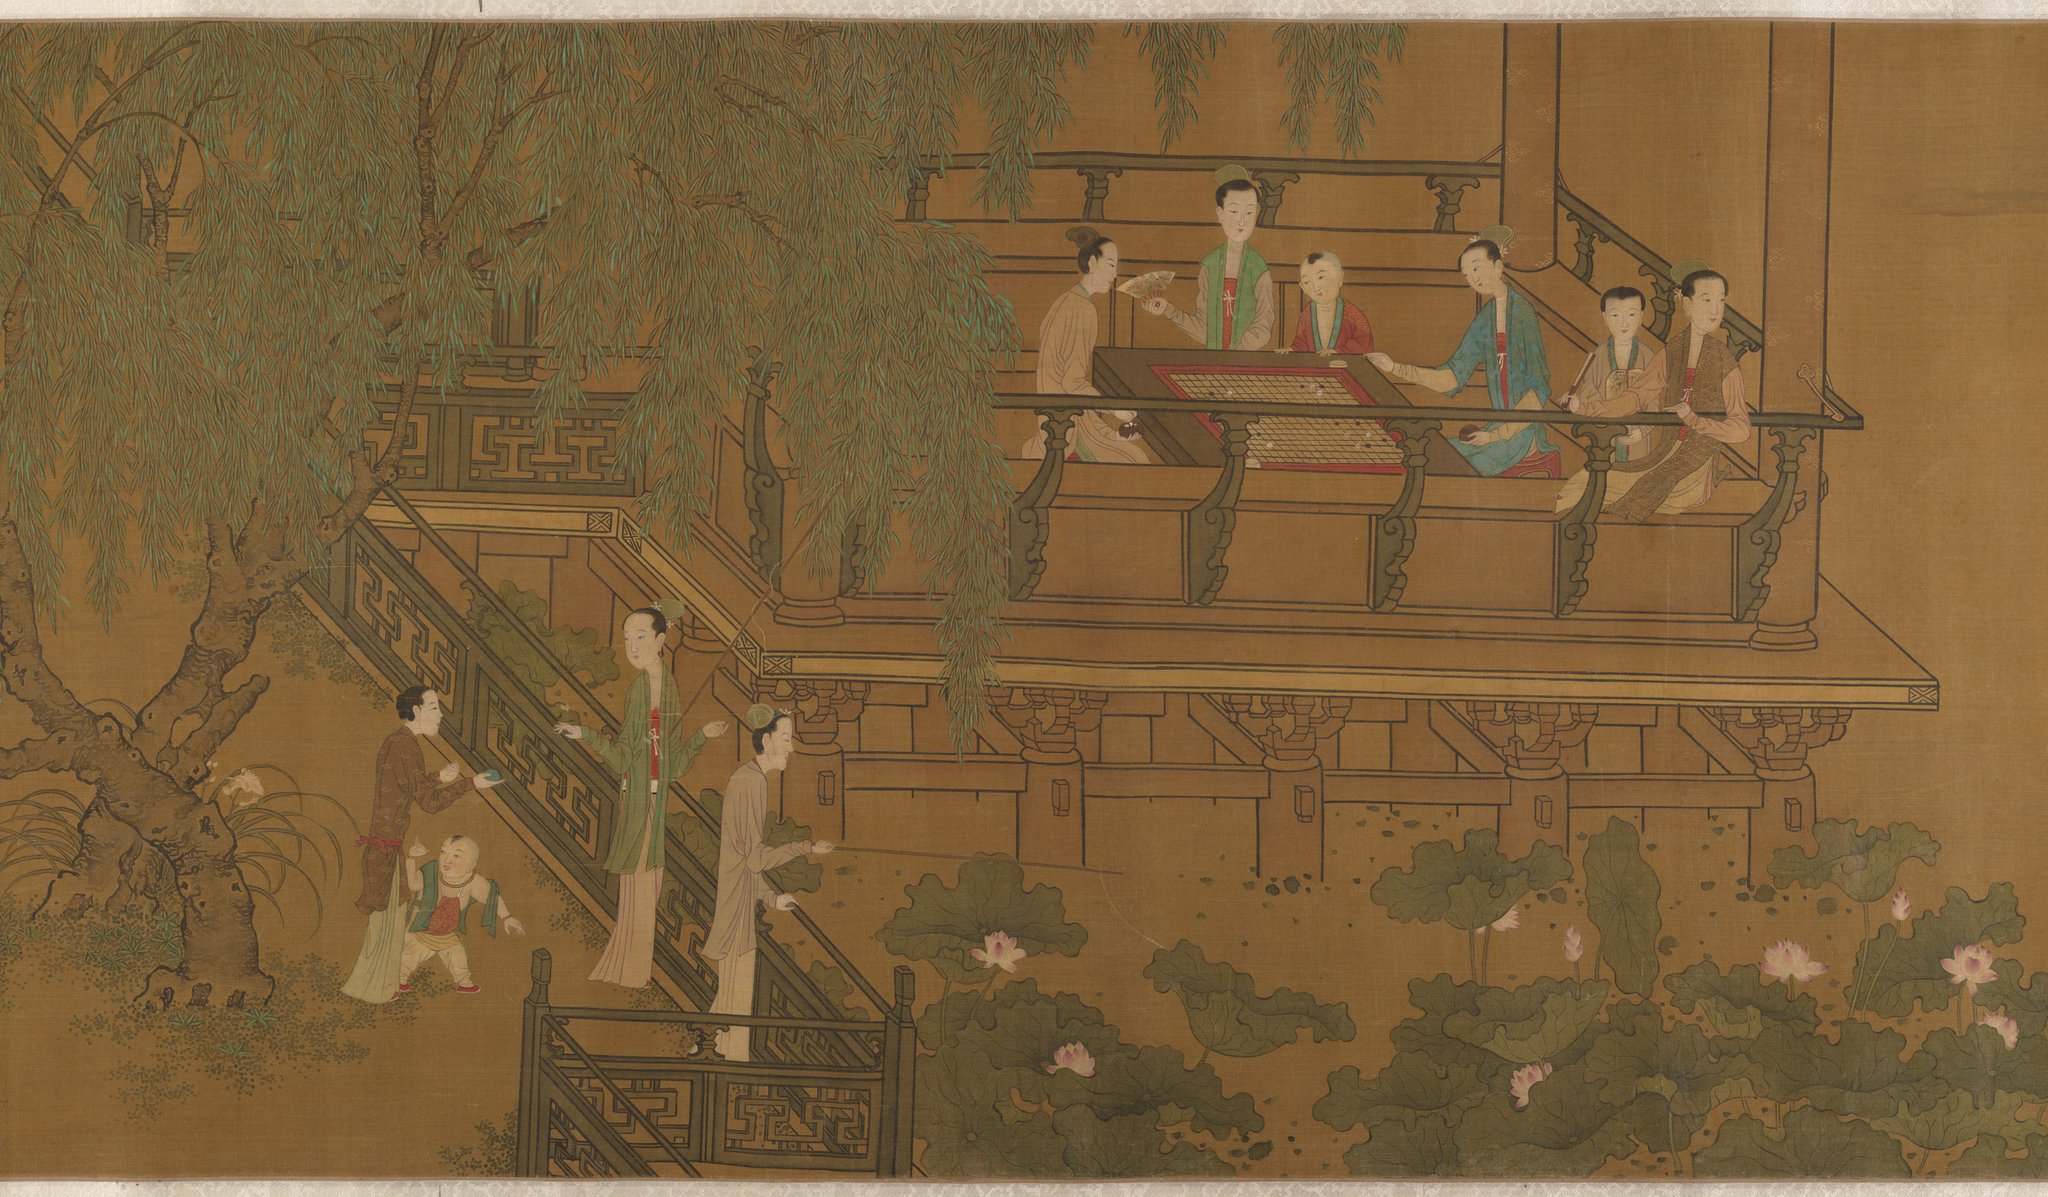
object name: handscroll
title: Women and children in a garden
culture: chinese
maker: unidentified artist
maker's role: artist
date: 1644-1911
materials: ink, silk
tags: gardens,women,games